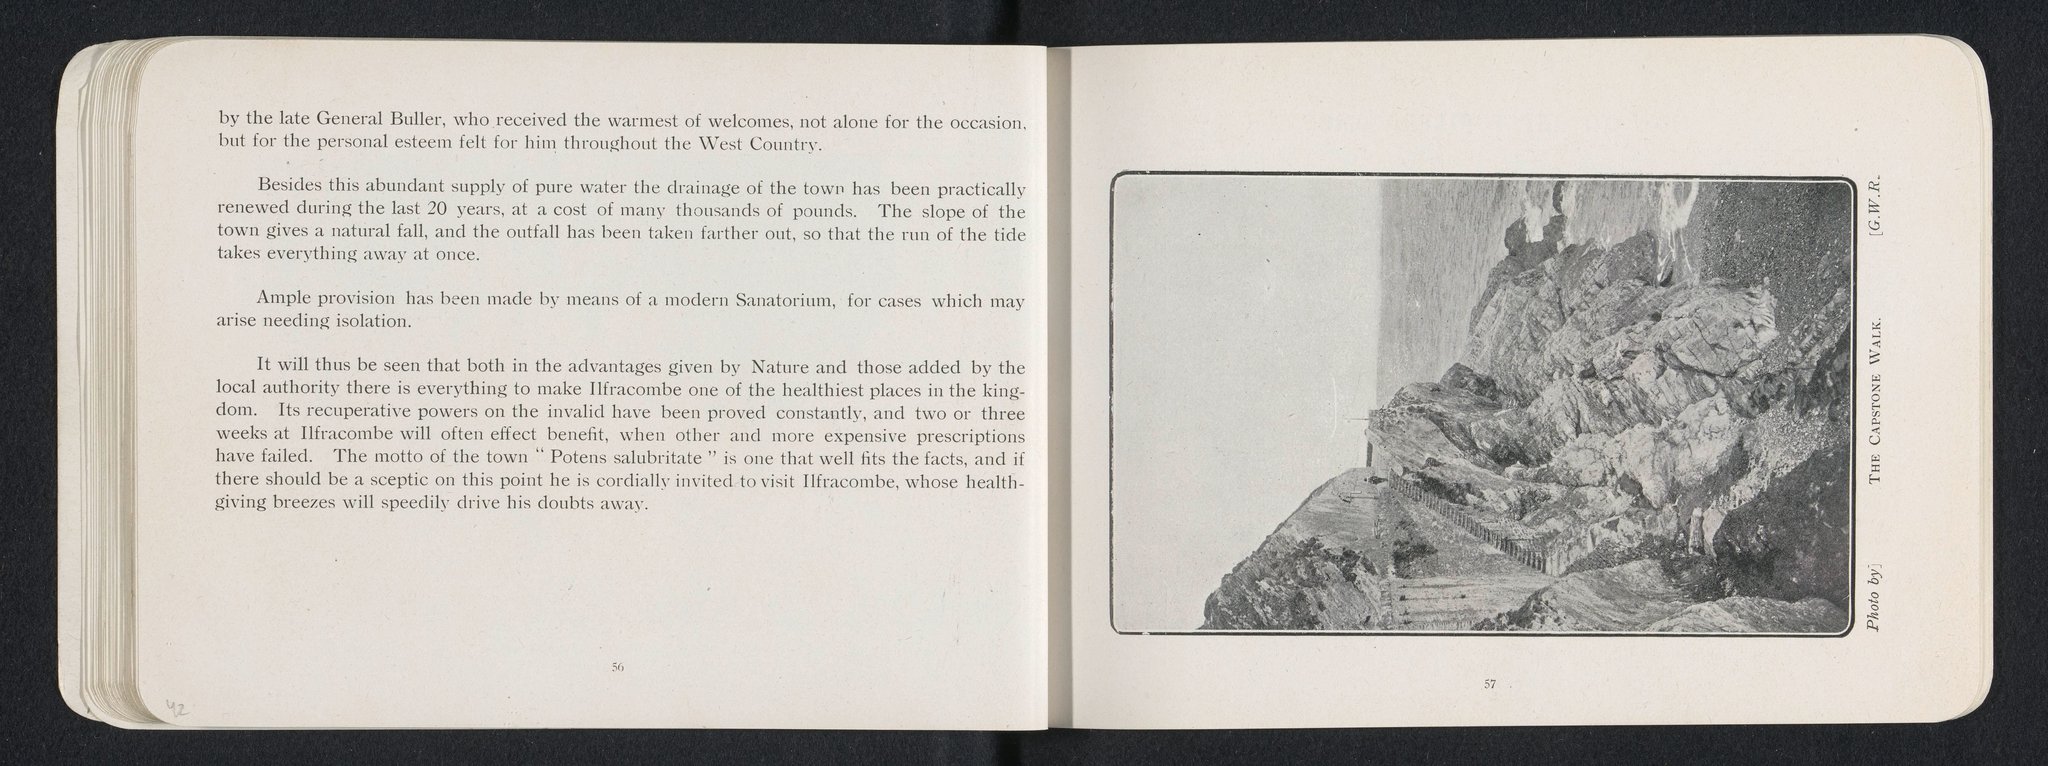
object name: photomechanical print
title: The Capstone walk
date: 1900-1920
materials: paper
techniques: autotype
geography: devon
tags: (high) hill, road, path